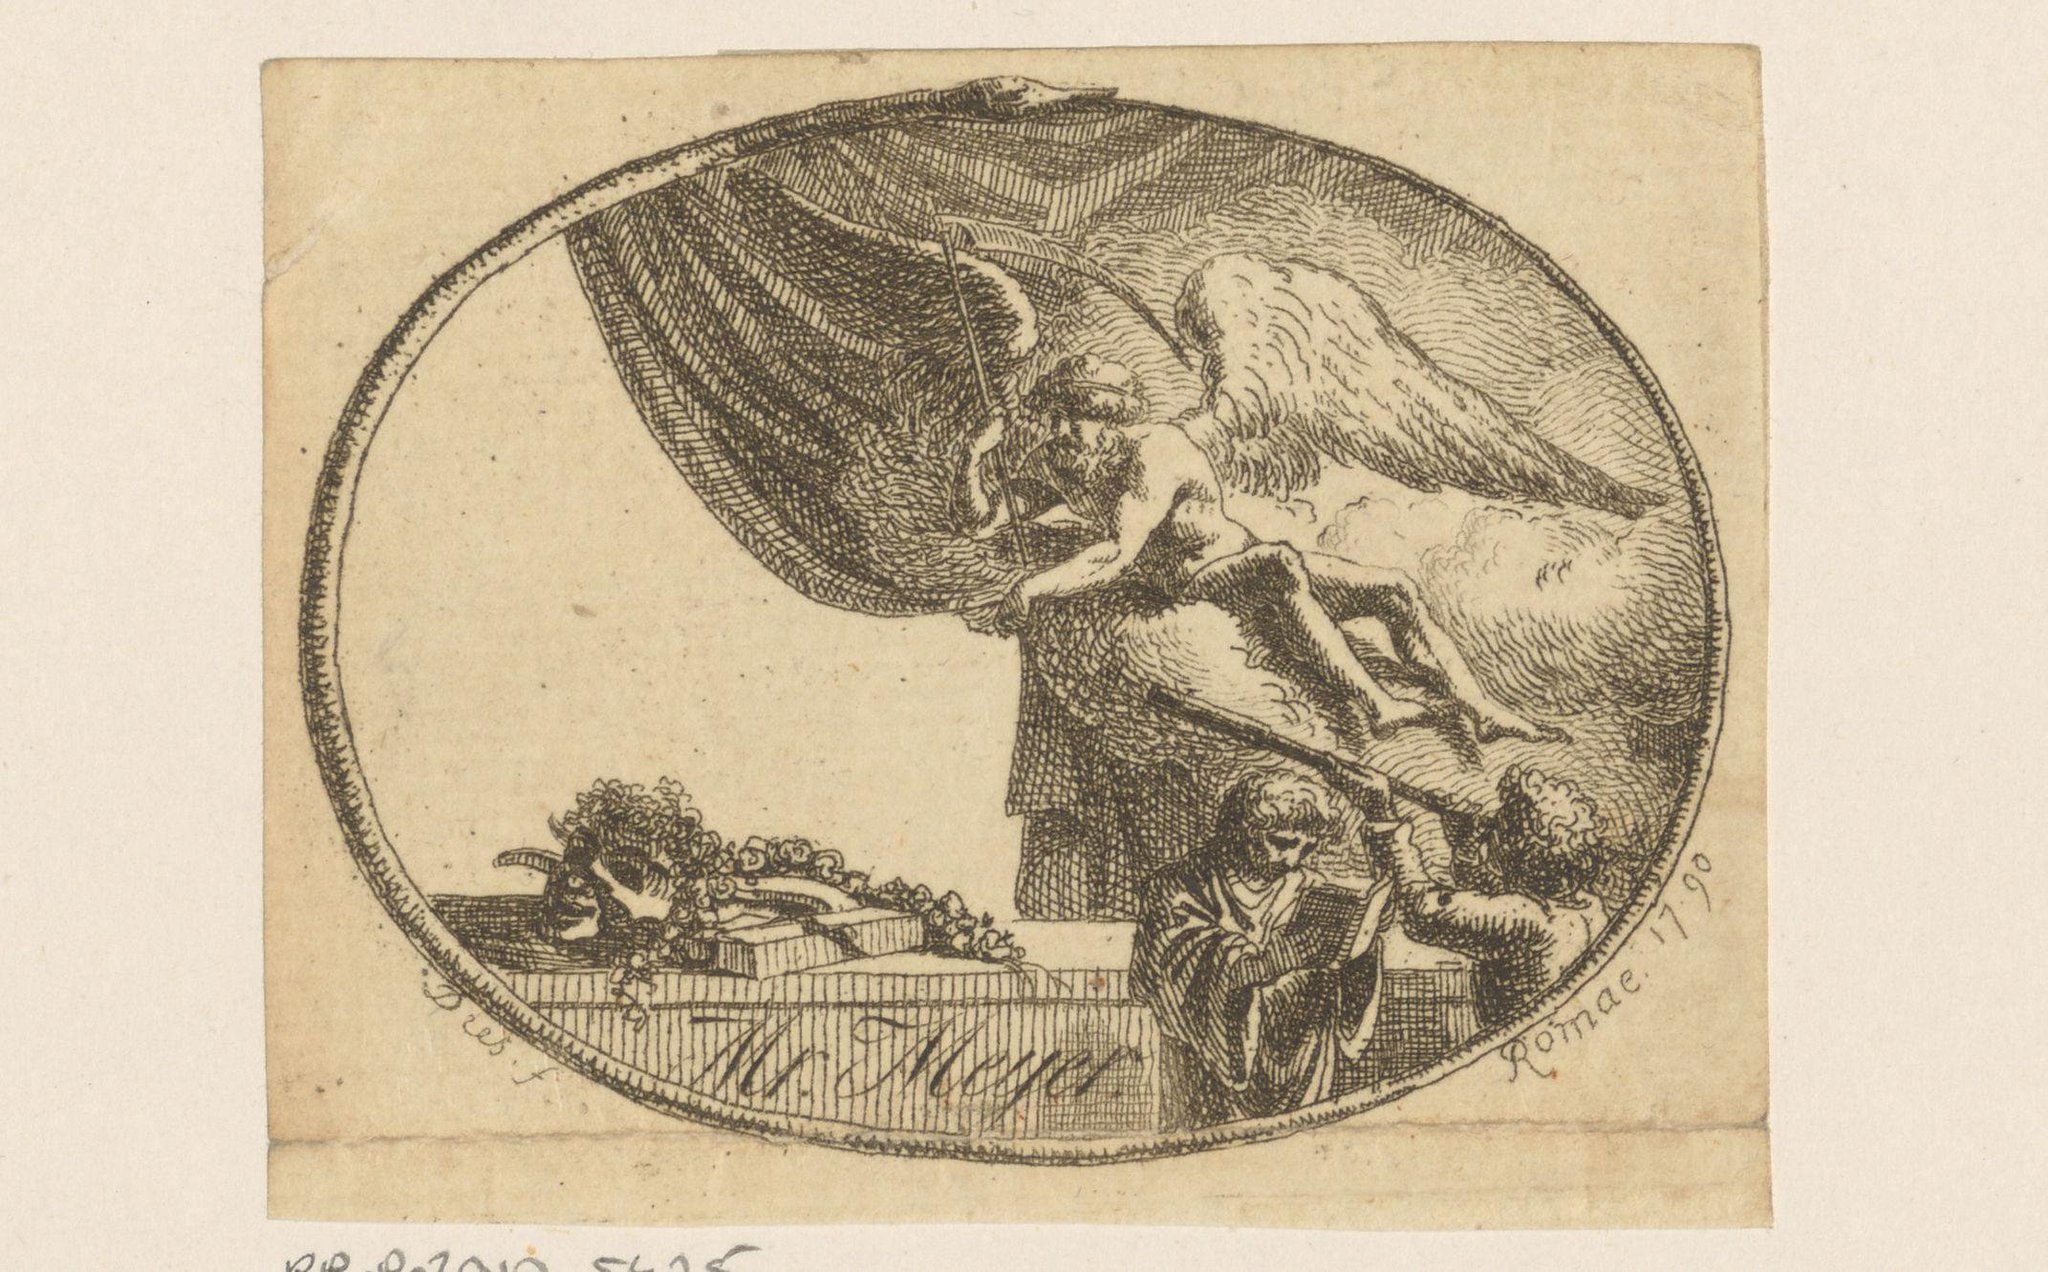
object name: bookplate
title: Ex libris van Mr. Meyer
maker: Anonymous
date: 1790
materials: paper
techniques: etching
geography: rome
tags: reading, telescope, father time, man with wings and scythe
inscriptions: date